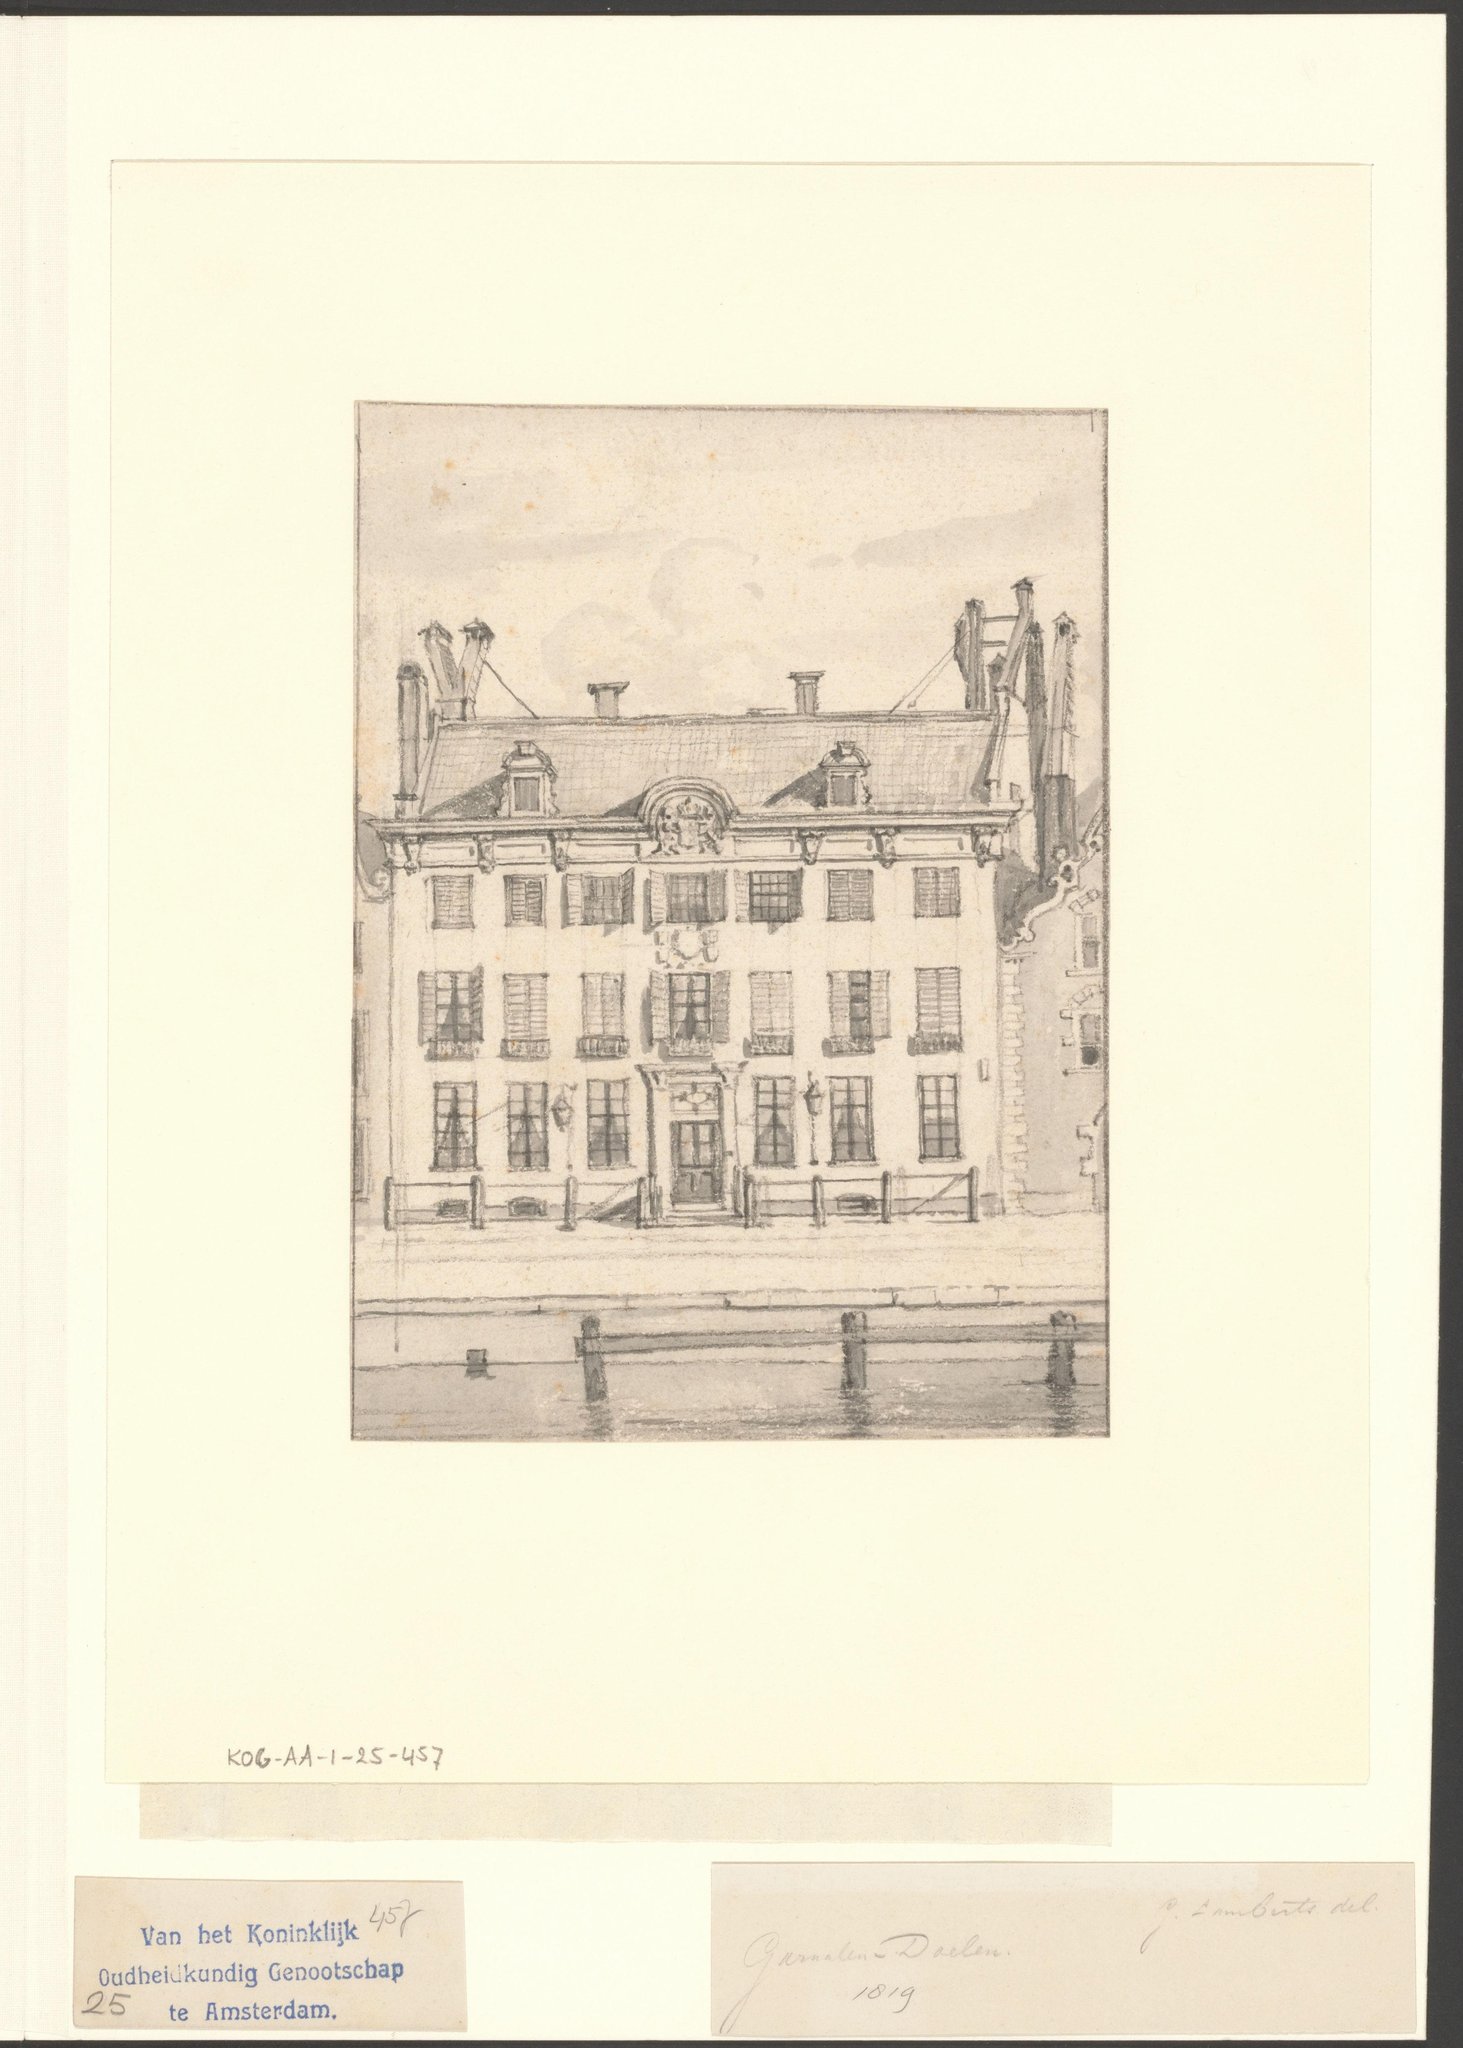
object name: drawing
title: Gezicht op de Garnalendoelen op het Singel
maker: gerrit lamberts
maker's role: bookseller, draughtsman, print maker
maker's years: 1776-1850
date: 1819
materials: chalk, ink, paper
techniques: brush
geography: amsterdam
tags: artillery range, firing range, shooting range ~ military training, city-view in general; 'veduta', canal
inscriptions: inscription: ‘Garnalen Doelen / 1819 / G. Lamberts del.’, stamp: ‘Van het Koninklijk / Oudheidkundig Genootschap / te Amsterdam / 25’, inscription: ‘Port. 25-457’, inscription: ‘Voorts door J. (...) als Logement afgeschetst.’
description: Onderwerpsrubriek binnen de Atlas Amsterdam: Doelen en Wachthuizen.